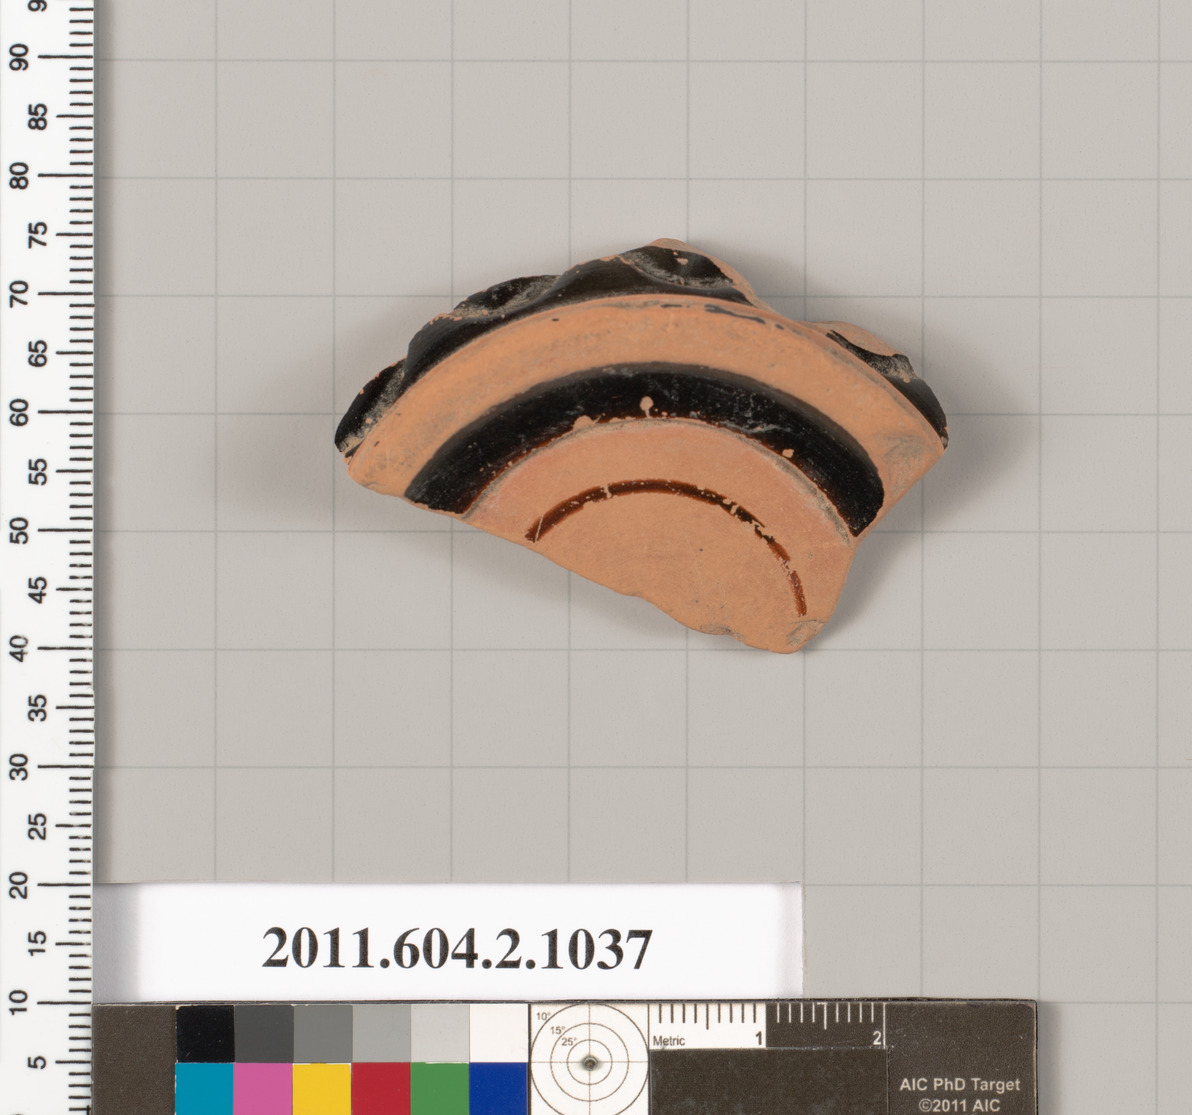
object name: oinochoe fragment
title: Terracotta fragment of an oinochoe (jug)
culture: greek, attic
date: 450-426 BCE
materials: terracotta